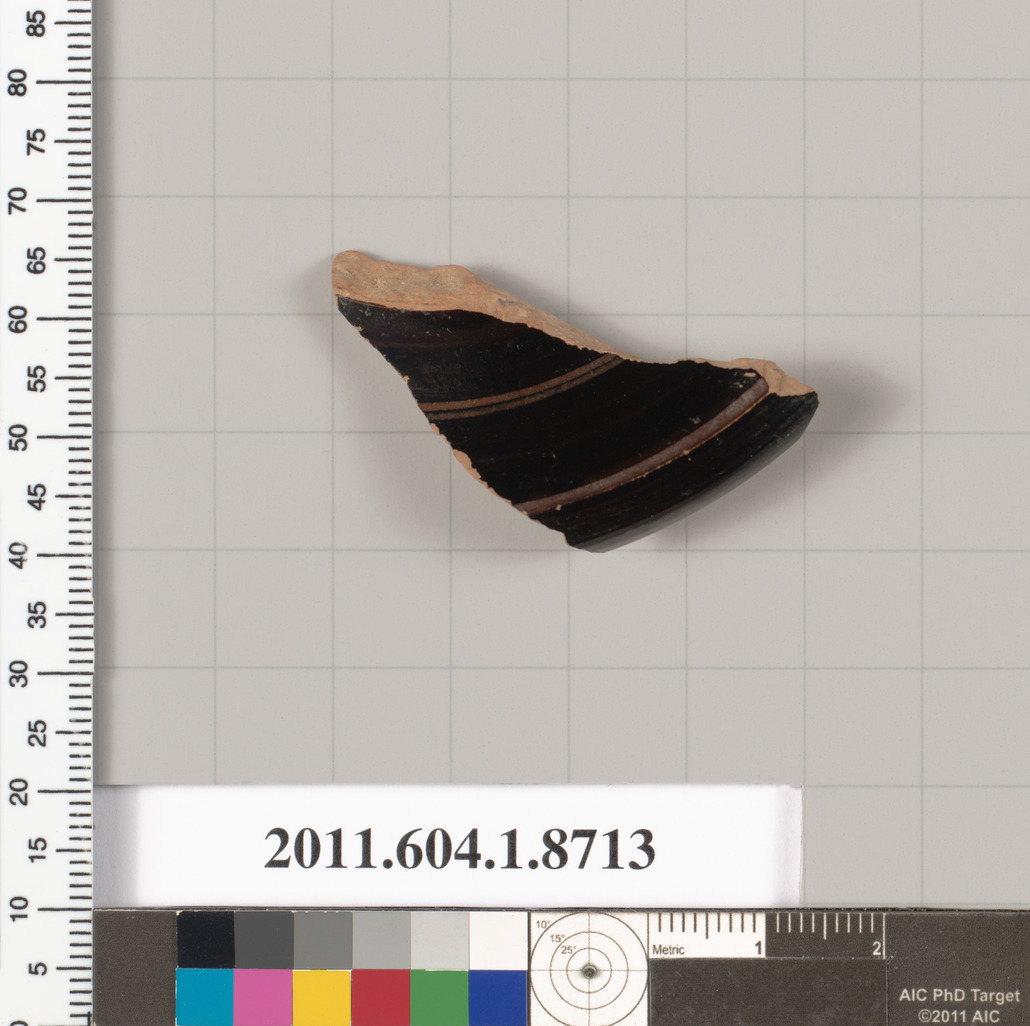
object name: kylix fragment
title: Terracotta fragment of a kylix (drinking cup)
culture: greek, attic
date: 600-401 BCE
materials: terracotta